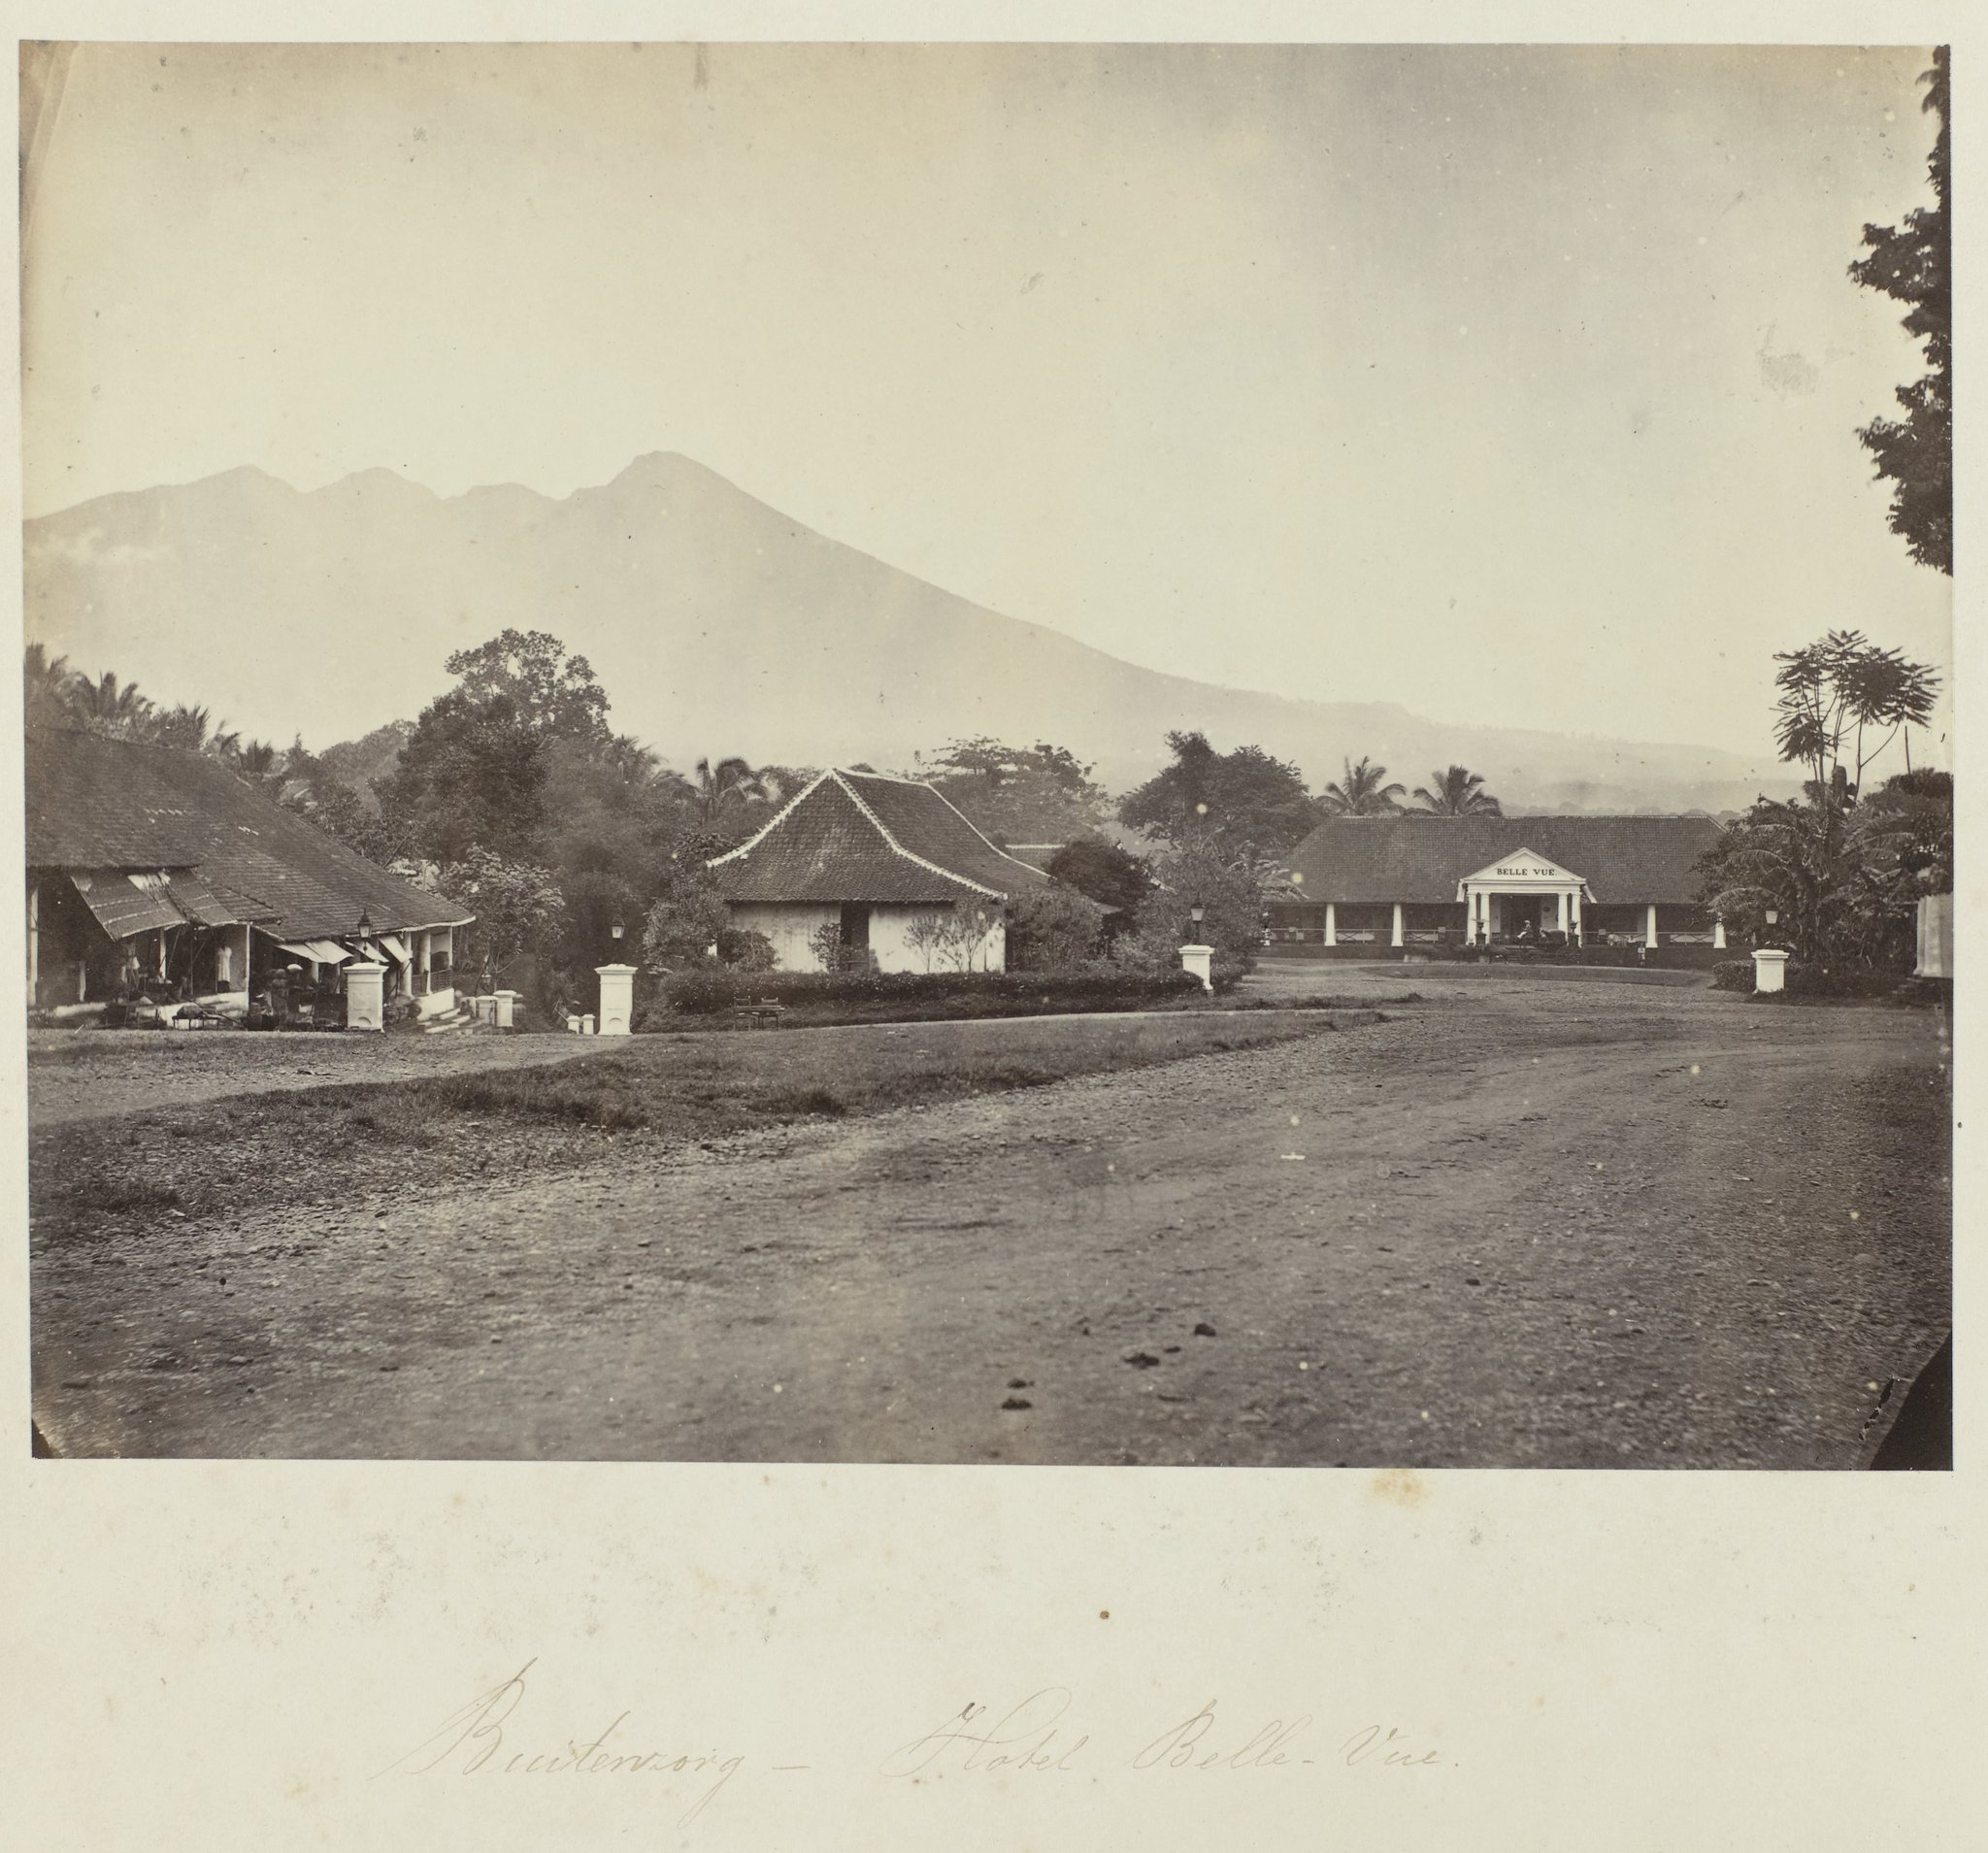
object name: photograph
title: Buitenzorg - Hotel Belle-Vue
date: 1863-1869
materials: photographic support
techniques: albumen print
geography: buitenzorg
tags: hotel, hostelry, inn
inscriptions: inscription: ‘Buitenzorg - Hotel Belle-Vue’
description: Gezicht op Hotel Belle-Vue in Buitenzorg. Onderdeel van het groene fotoalbum met foto's van Java, uit het bezit van apotheker Specht-Grijp, die in 1865 vanuit Batavia naar Nederland terugkeerde.